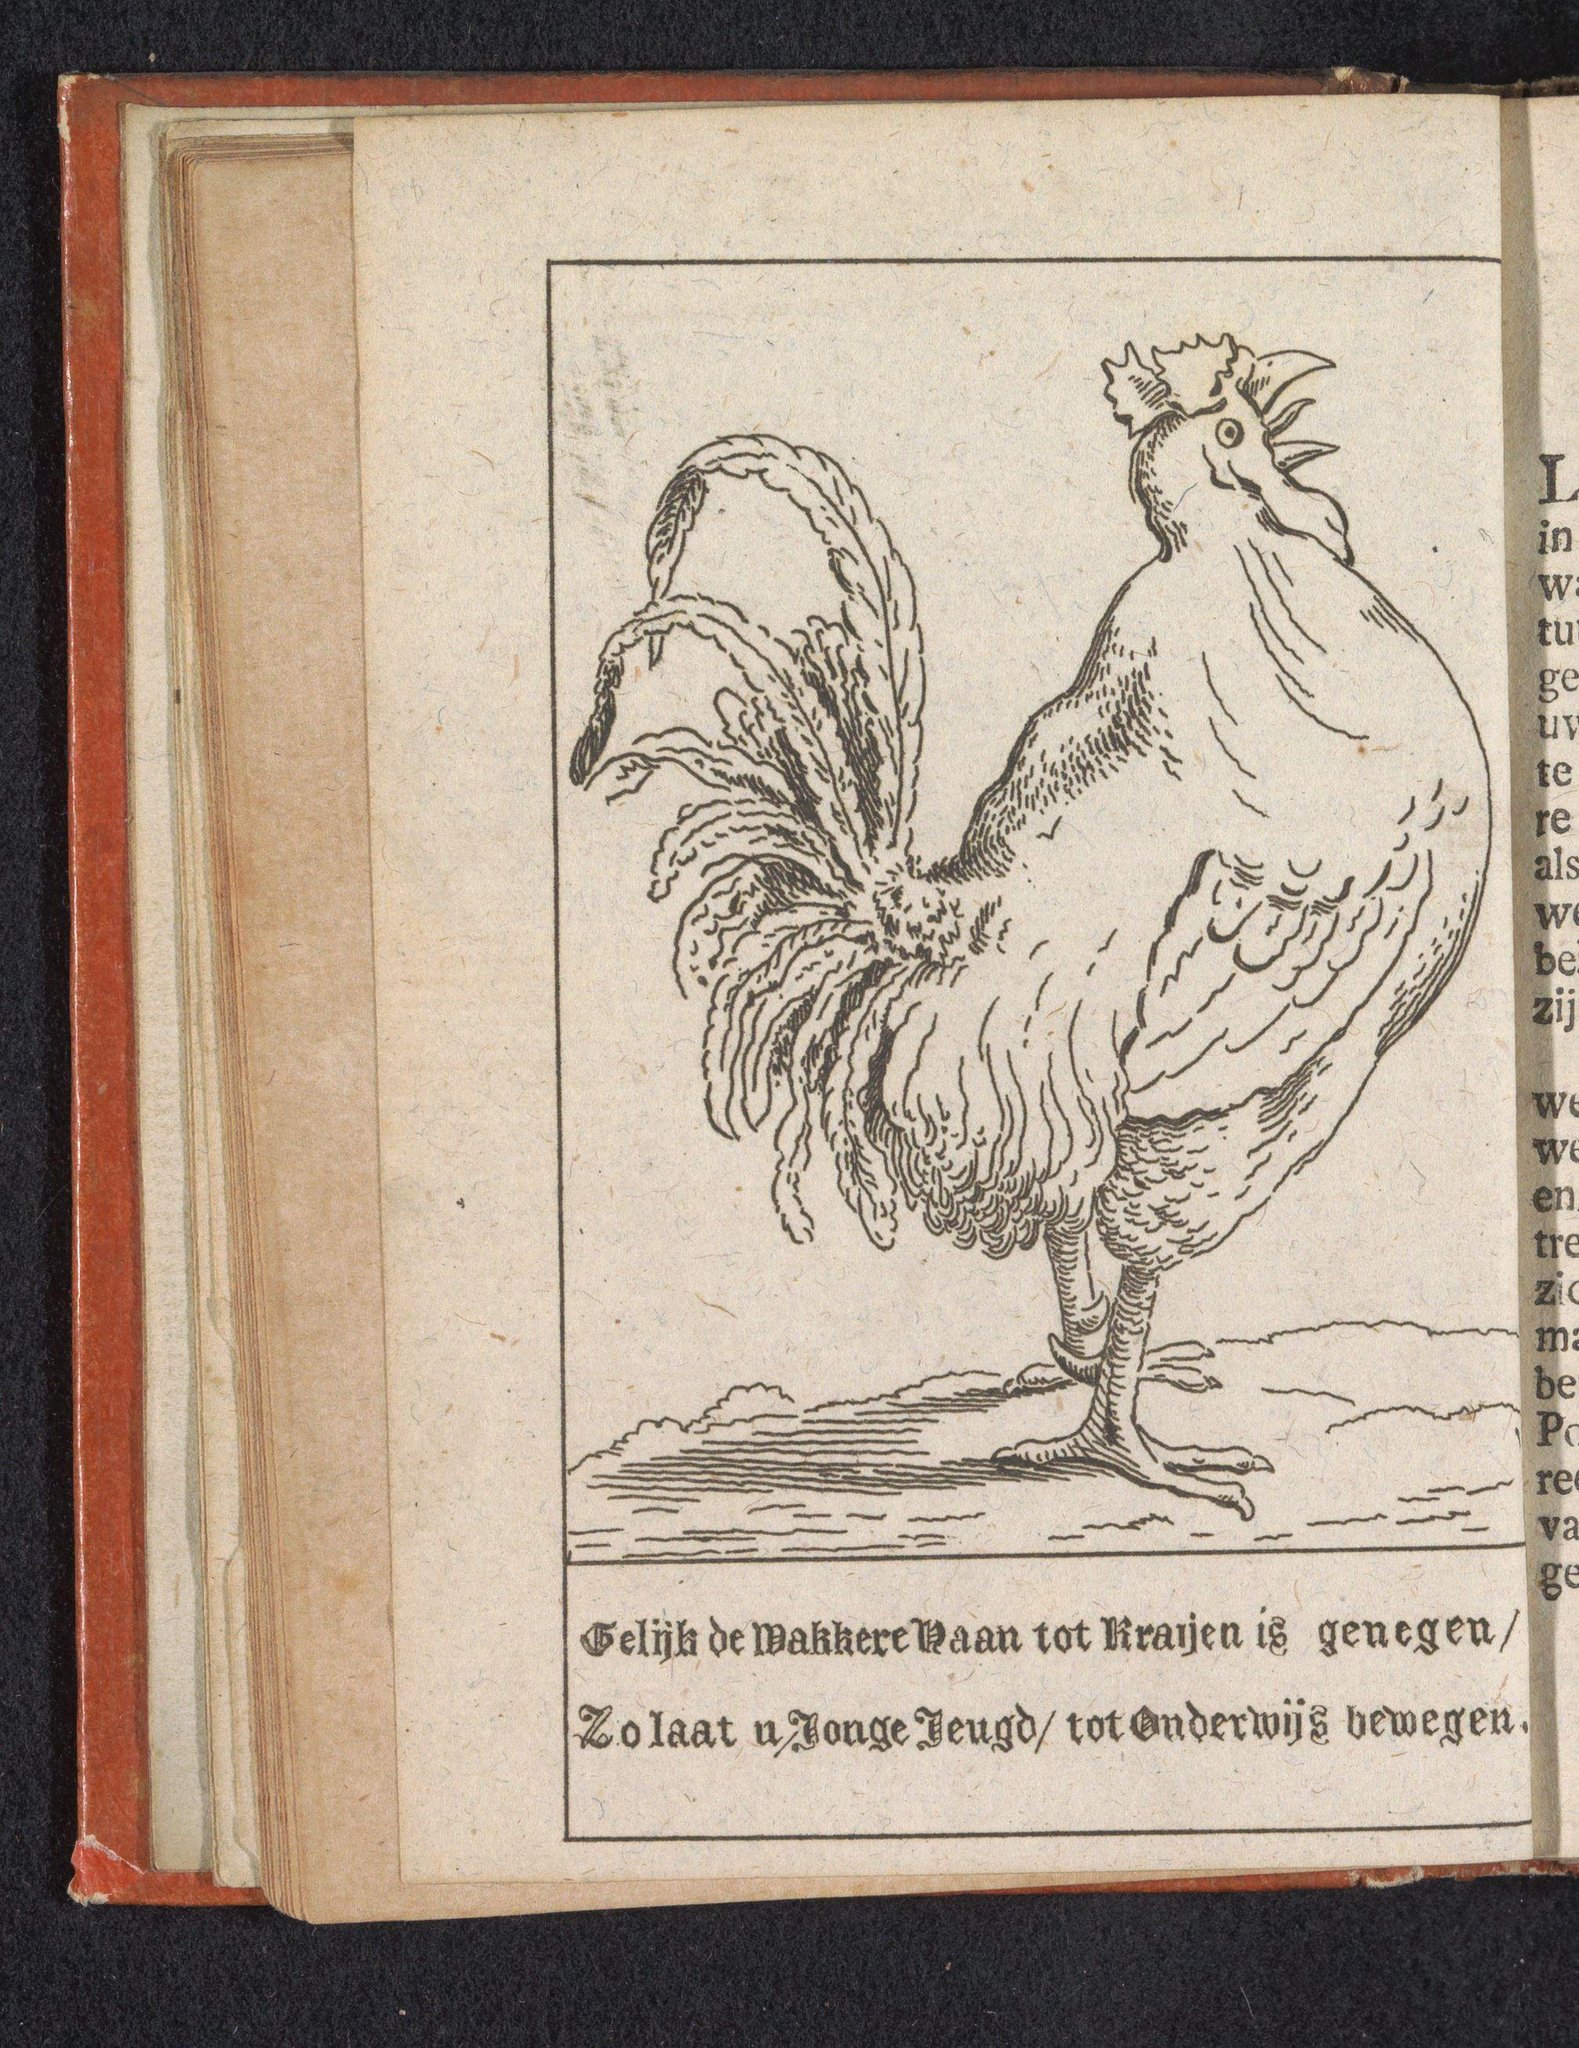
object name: book illustration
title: Haan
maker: pieter van woensel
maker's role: print maker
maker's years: 1747-1808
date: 1792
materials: paper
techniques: etching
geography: northern netherlands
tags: fowl (cock, hen, chicken, etc.)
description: Gebruikt als illustratie in: De Lantaarn voor 1792; in het exemplaar in de Rijksmuseum Research Library met signatuur: 305-G-1.